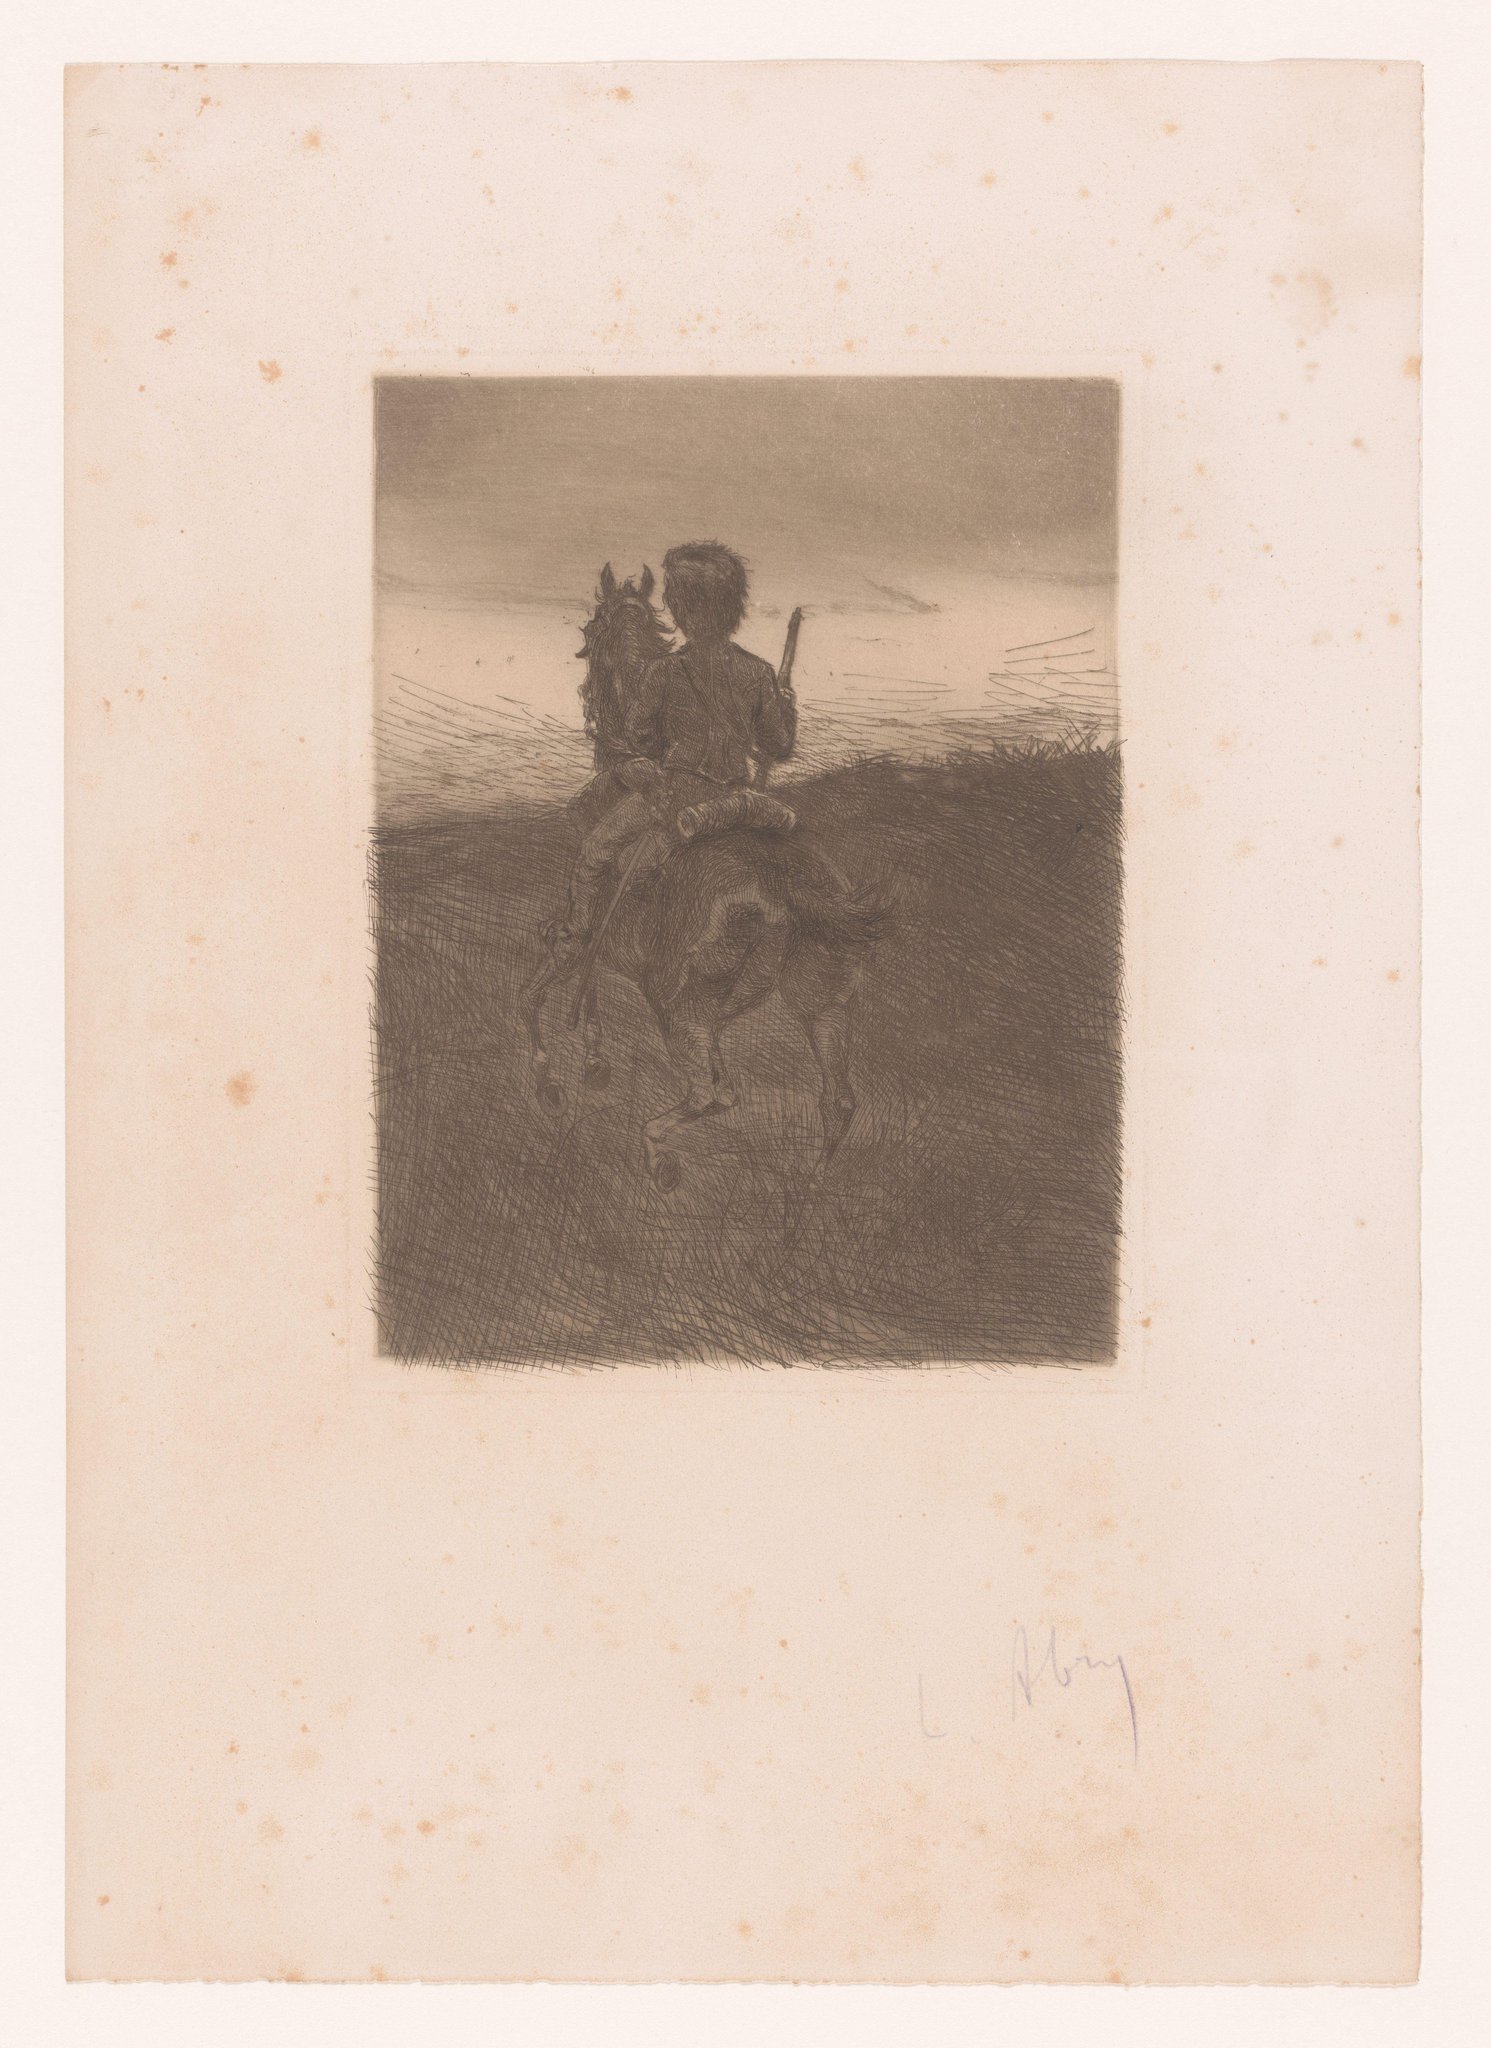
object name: print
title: Landschap met een huzaar van achteren gezien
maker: leon eugène auguste abry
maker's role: print maker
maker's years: 1857-1905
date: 1867-1905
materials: paper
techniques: drypoint, etching, intaglio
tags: private soldier (+ cavalry, horsemen)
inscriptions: collector's mark: Lugt 2228